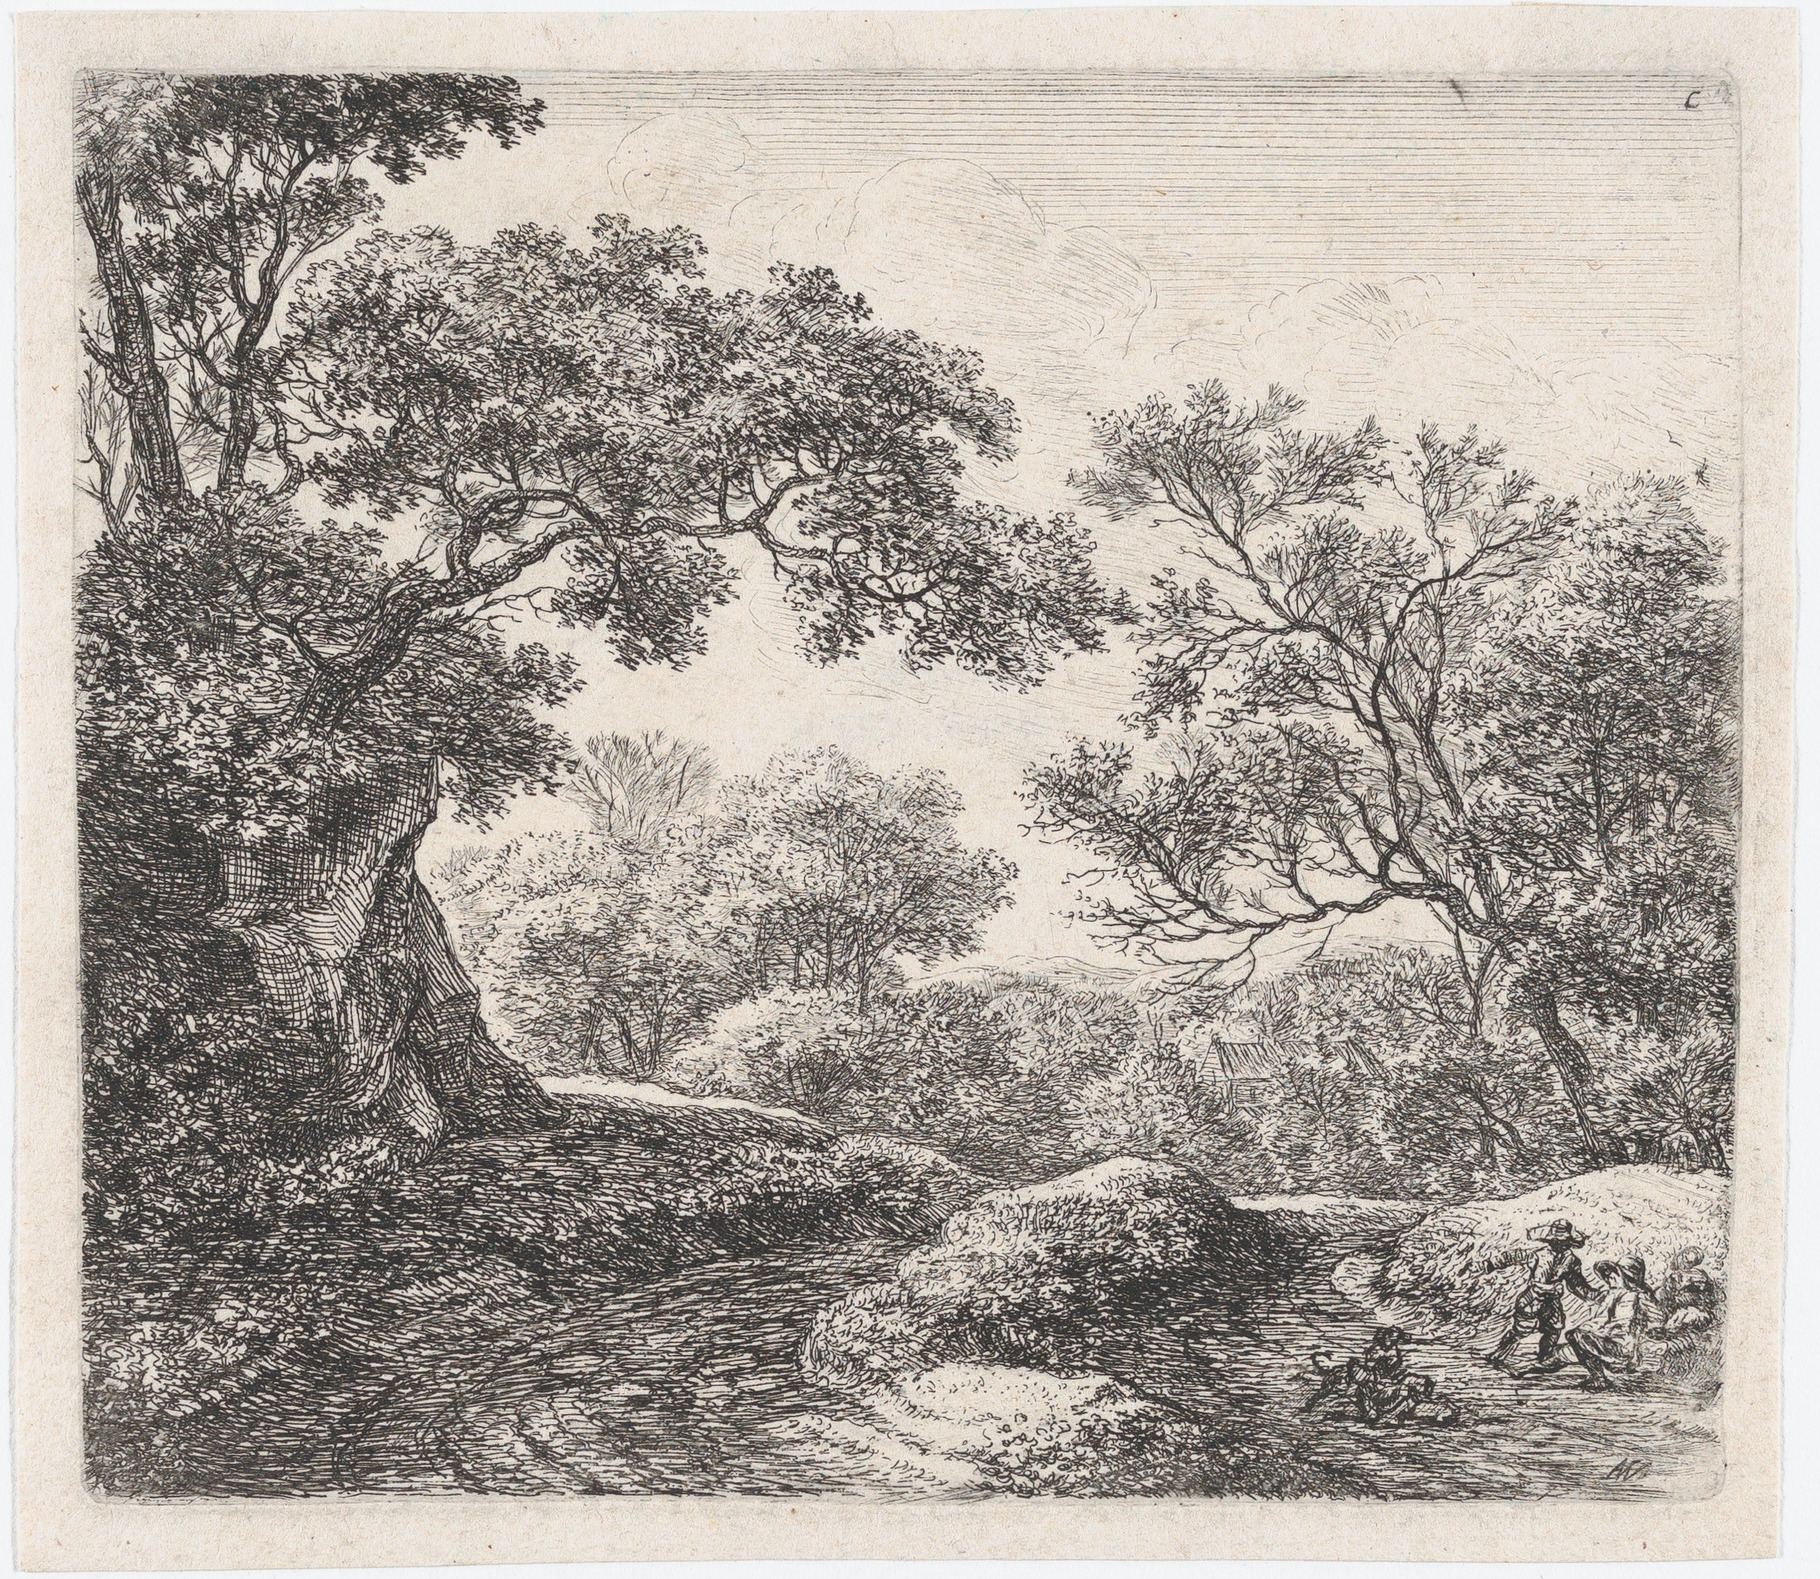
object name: print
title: Three Boys and Their Dogs (L'Allée dans le Bois)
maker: anthonie waterloo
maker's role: artist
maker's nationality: dutch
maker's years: 1609-1690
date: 1601-1700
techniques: etching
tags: boys,dogs,trees